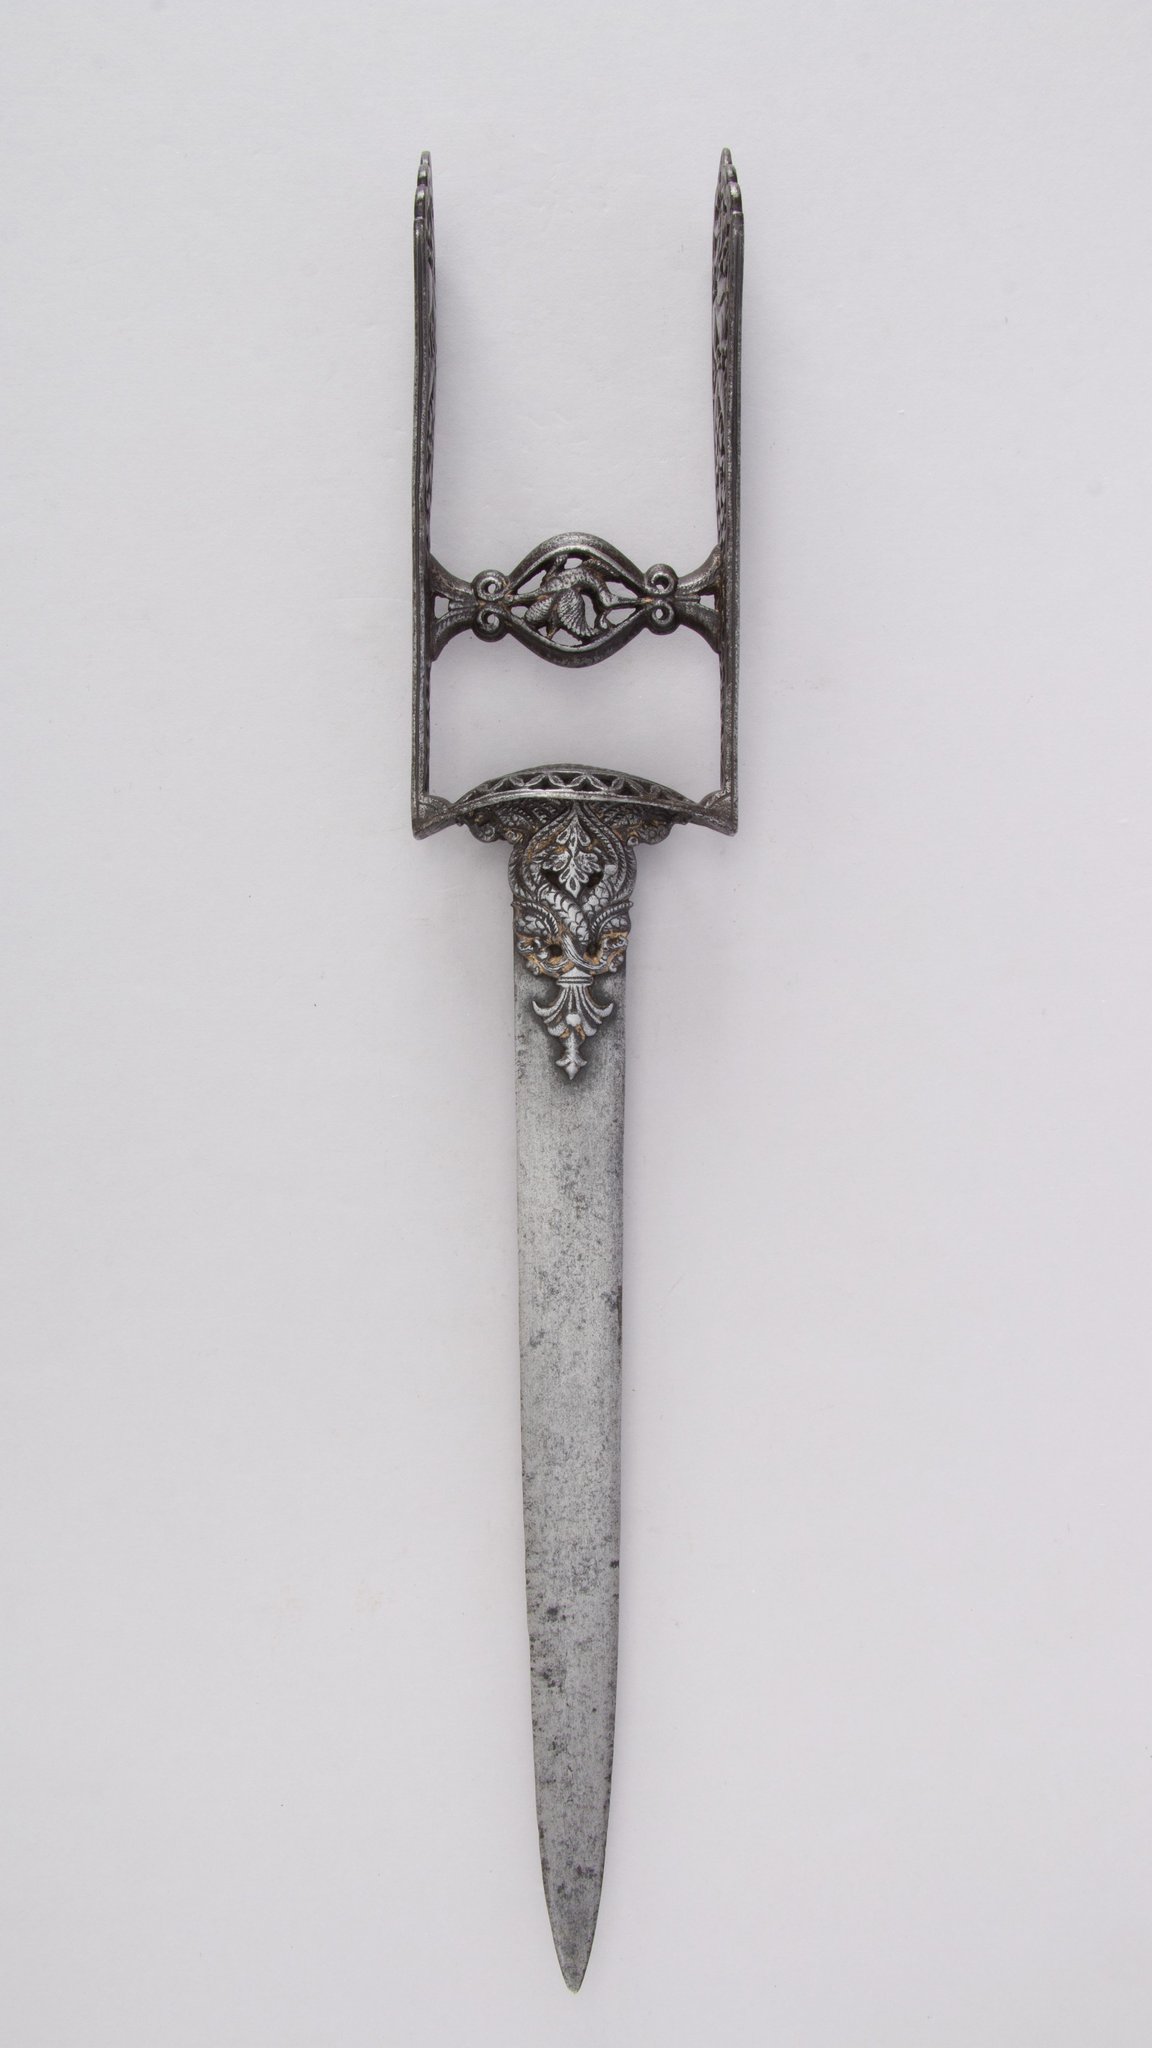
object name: dagger katar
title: Dagger (Katar)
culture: indian or european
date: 1601-1700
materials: steel